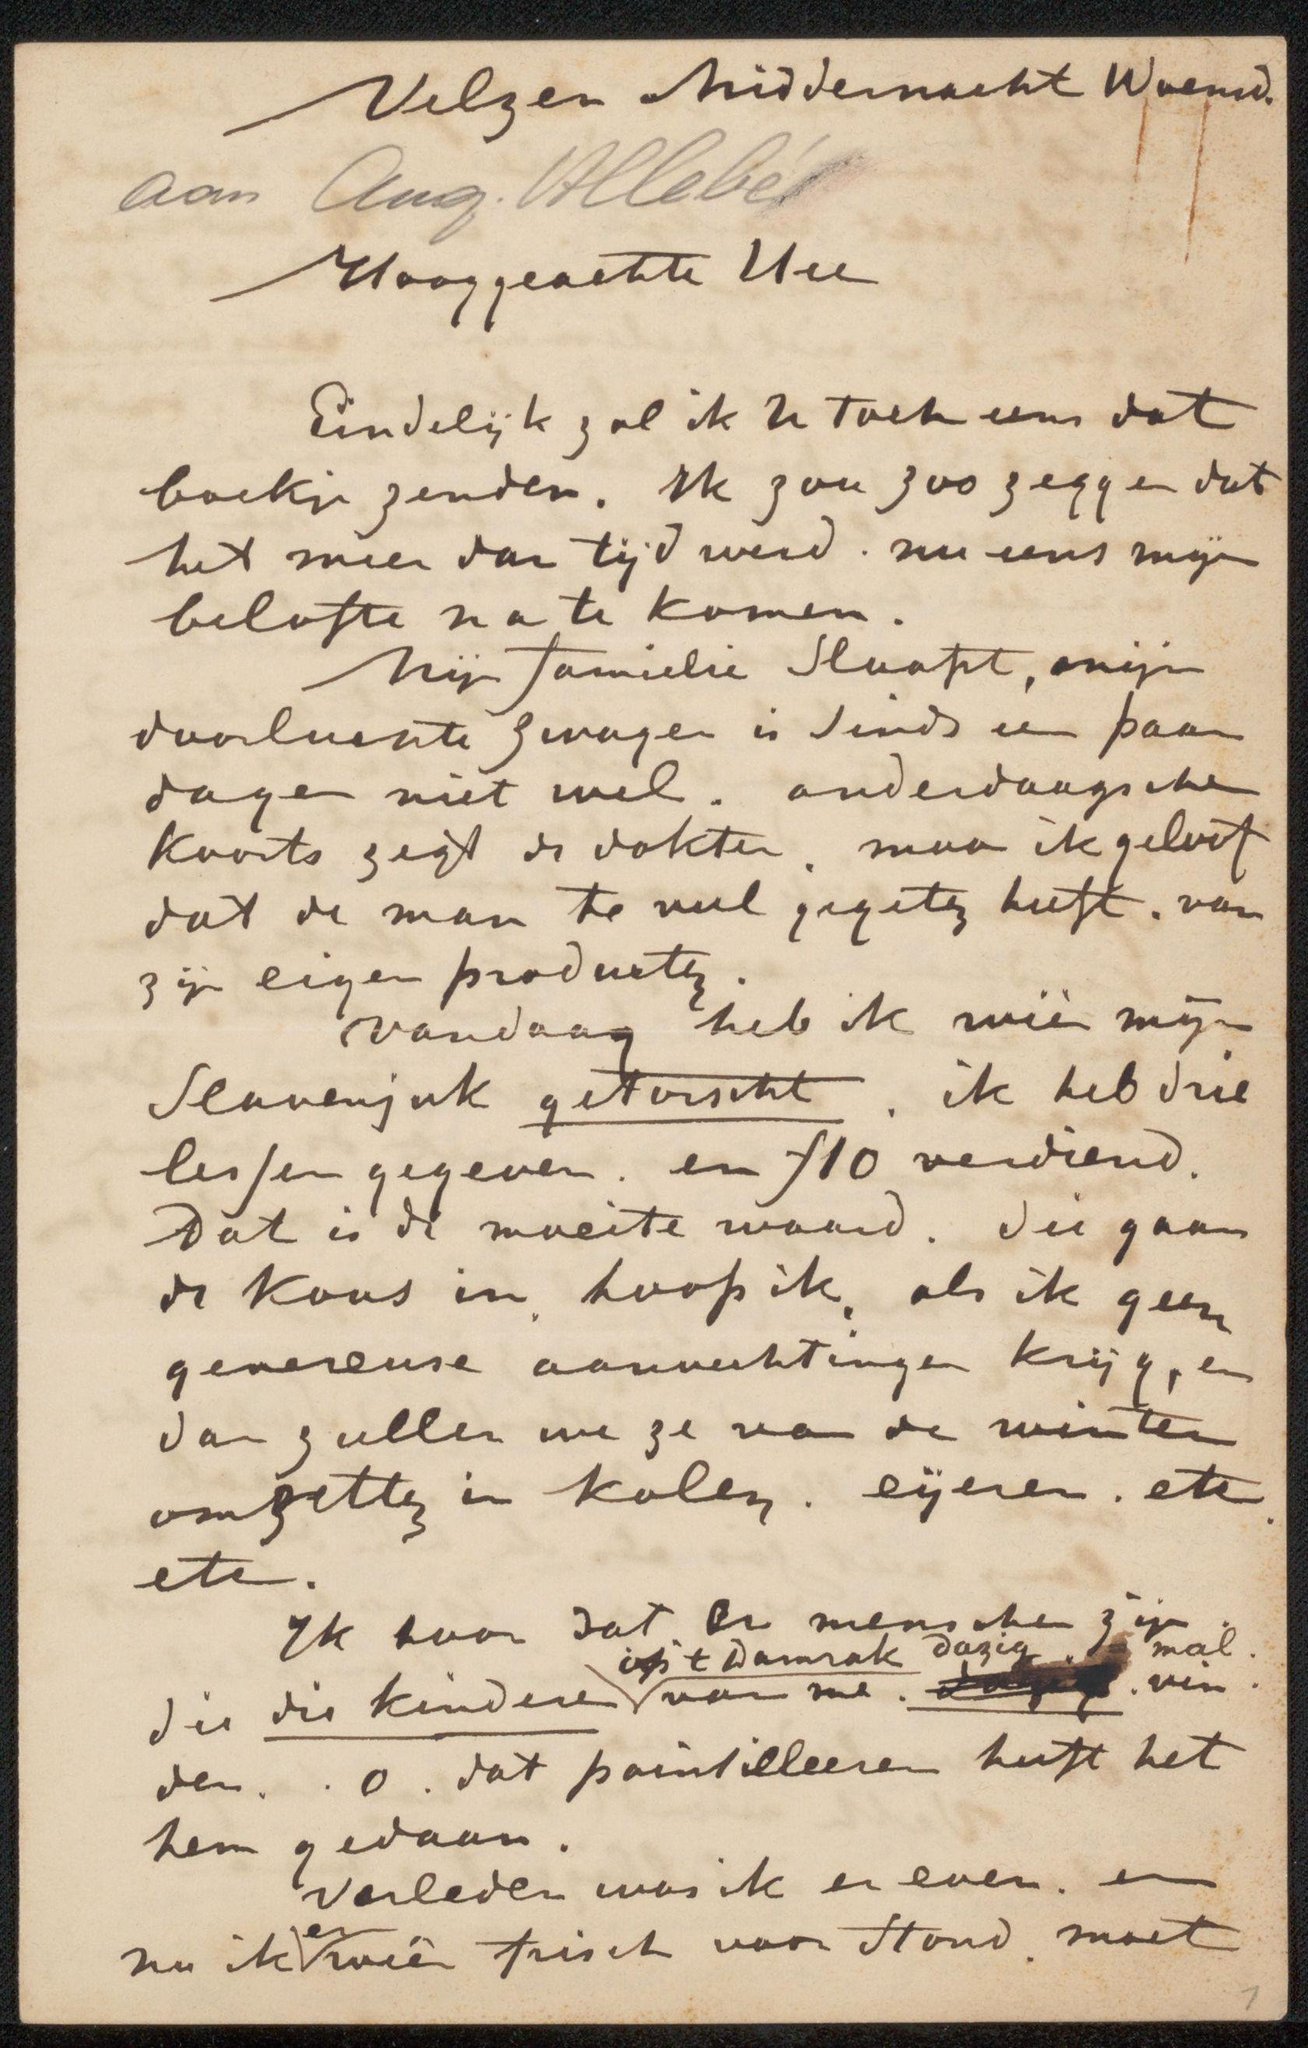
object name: letter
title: Brief aan onbekend, mogelijk August Allebé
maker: jac van looij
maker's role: draughtsman, painter, print maker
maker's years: 1855-1930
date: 1865-1930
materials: ink, paper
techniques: pen, writing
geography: velzen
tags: dordrecht, amsterdam, designer, jan veth, willem maris, jacob maris, painter, print maker, james abbott mcneill whistler, kitty van vloten, photography, cinematography, family life, education, tuition of the artist (in general), painting (including book-illumination, miniature-painting), historical persons (portraits and scenes from the life), money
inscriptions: collector's mark: ‘RPK’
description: Brief bevat aantekening `aan Aug. Allebé' in latere hand.